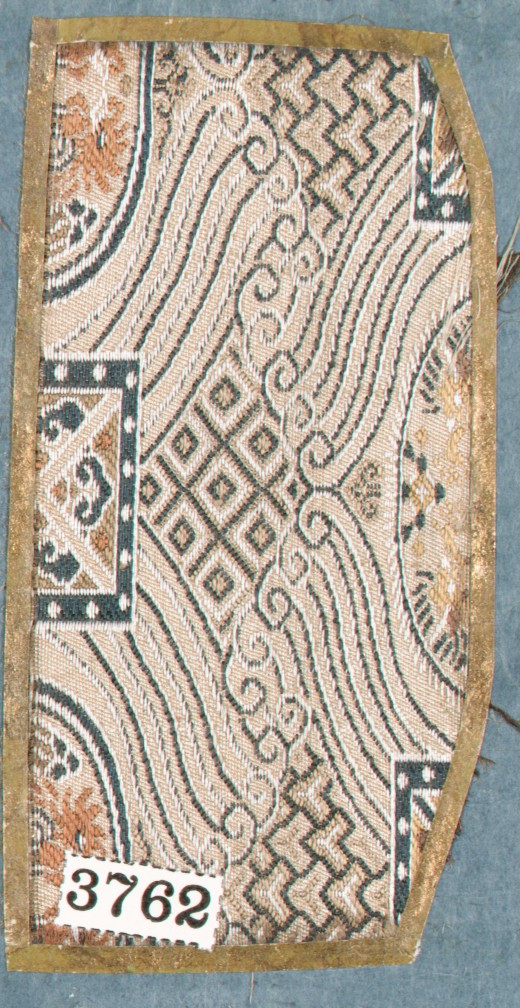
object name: sample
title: Textile Sample from Sample Book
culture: japanese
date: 1801-1900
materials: silk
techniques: tapestry